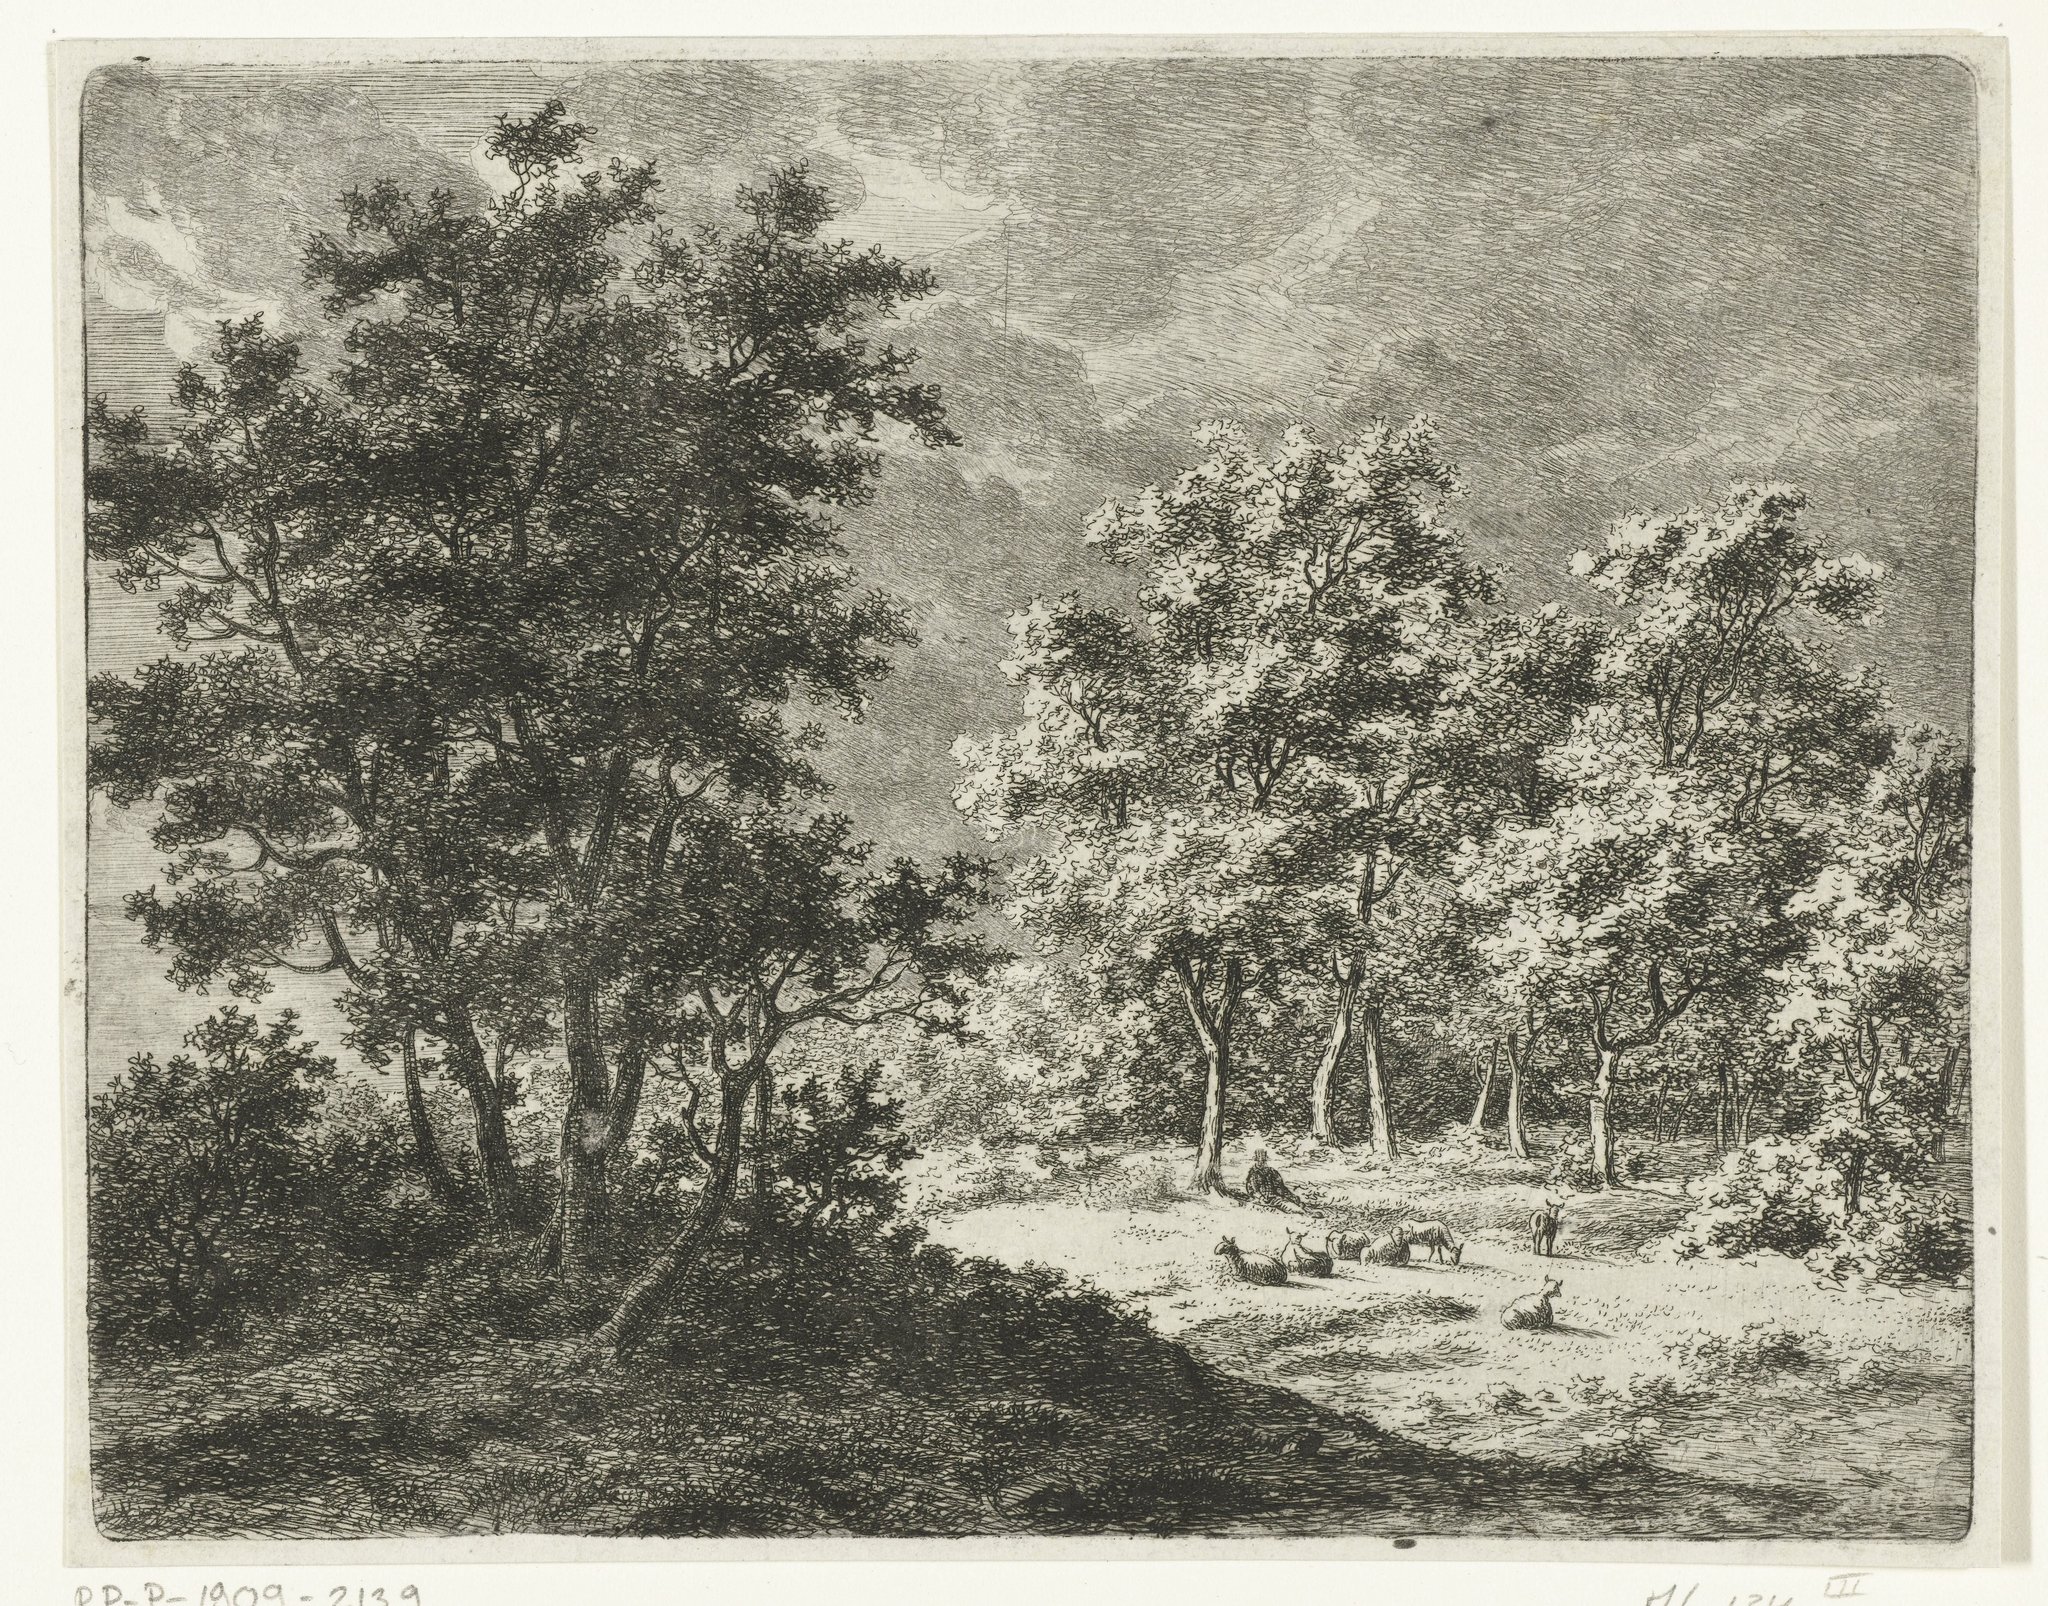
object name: print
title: Landschap met herder en zeven schapen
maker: ernst willem jan bagelaar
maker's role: draughtsman, print maker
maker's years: 1775-1837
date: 1798-1837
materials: paper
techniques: drypoint, etching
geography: netherlands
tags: herding, herdsman, herdswoman, shepherd, shepherdess, cowherd, etc., landscapes in the temperate zone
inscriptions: collector's mark: Lugt 2228